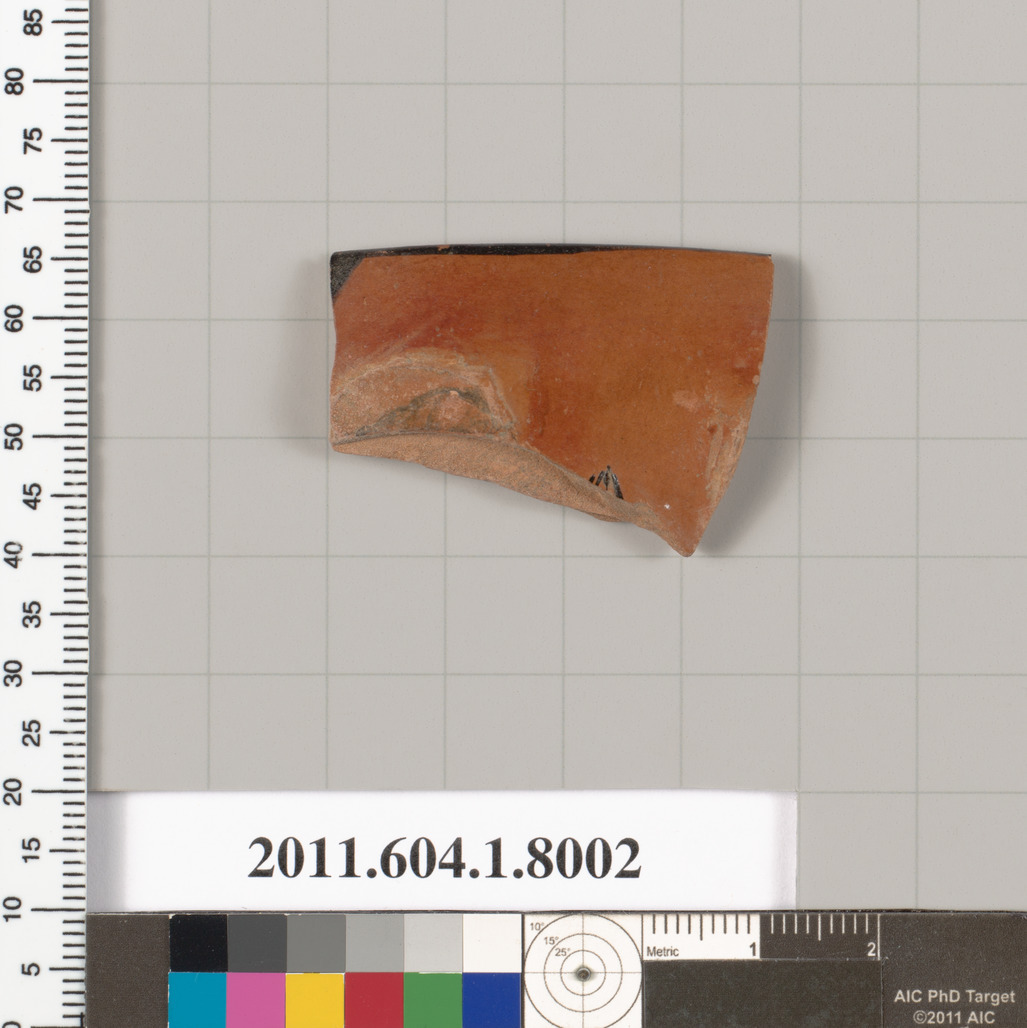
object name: kylix fragment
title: Terracotta rim fragment of a kylix (drinking cup)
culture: greek, attic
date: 460-450 BCE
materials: terracotta